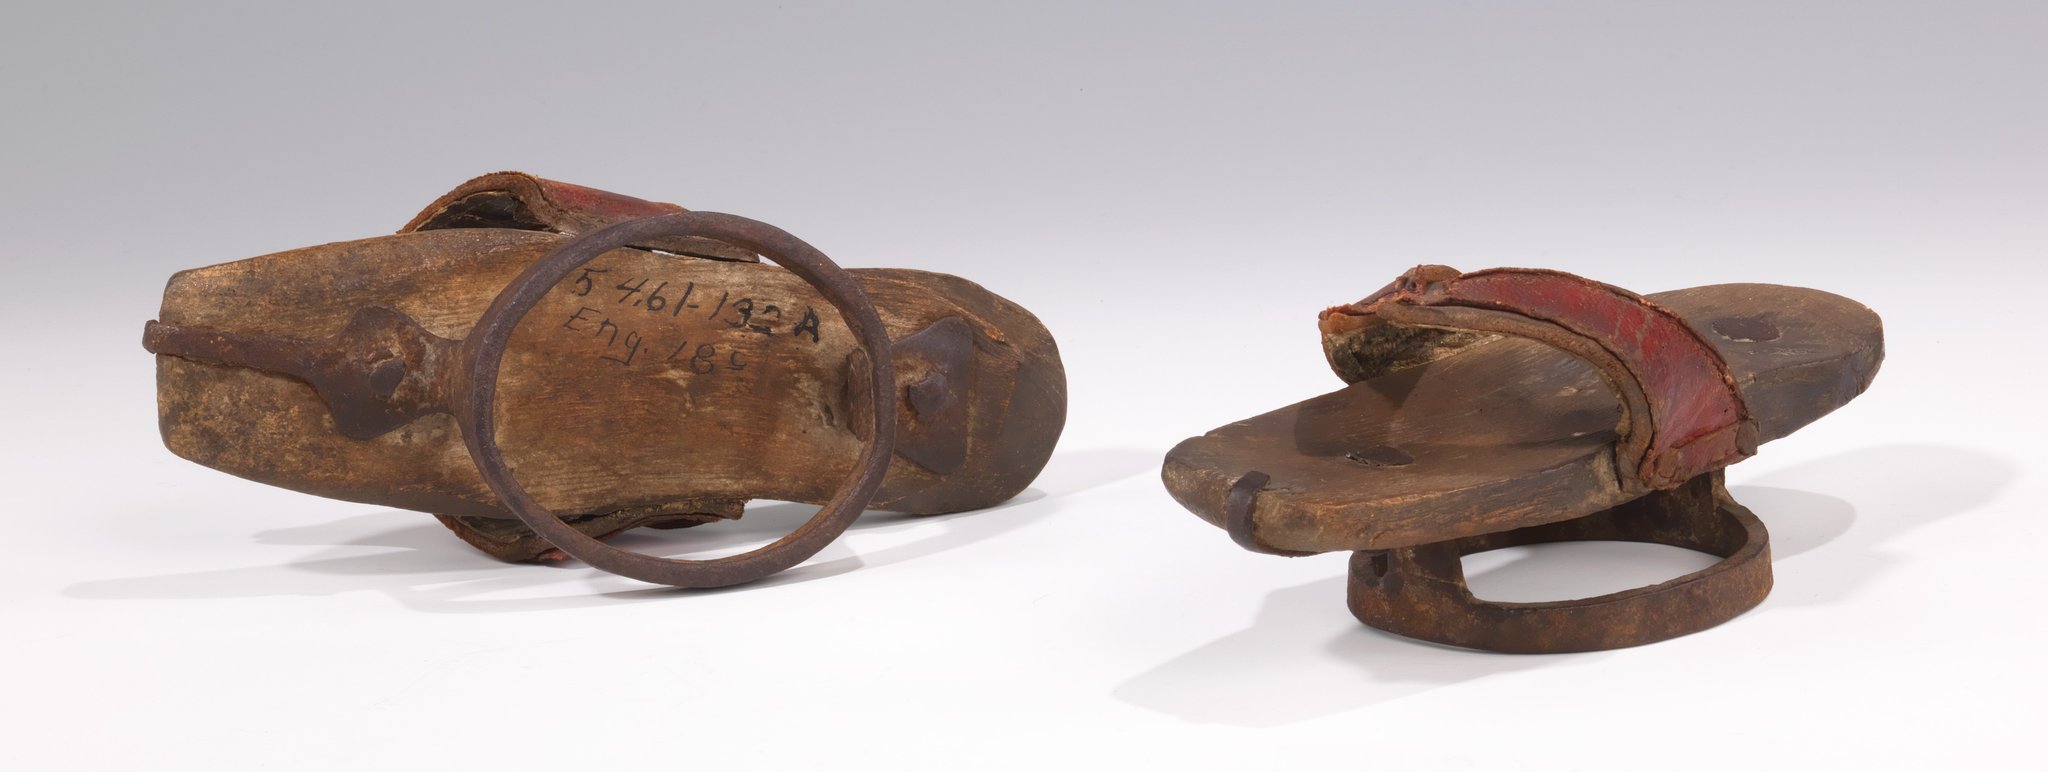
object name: patten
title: Pattens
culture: british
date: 1830-1850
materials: leather, metal, wood